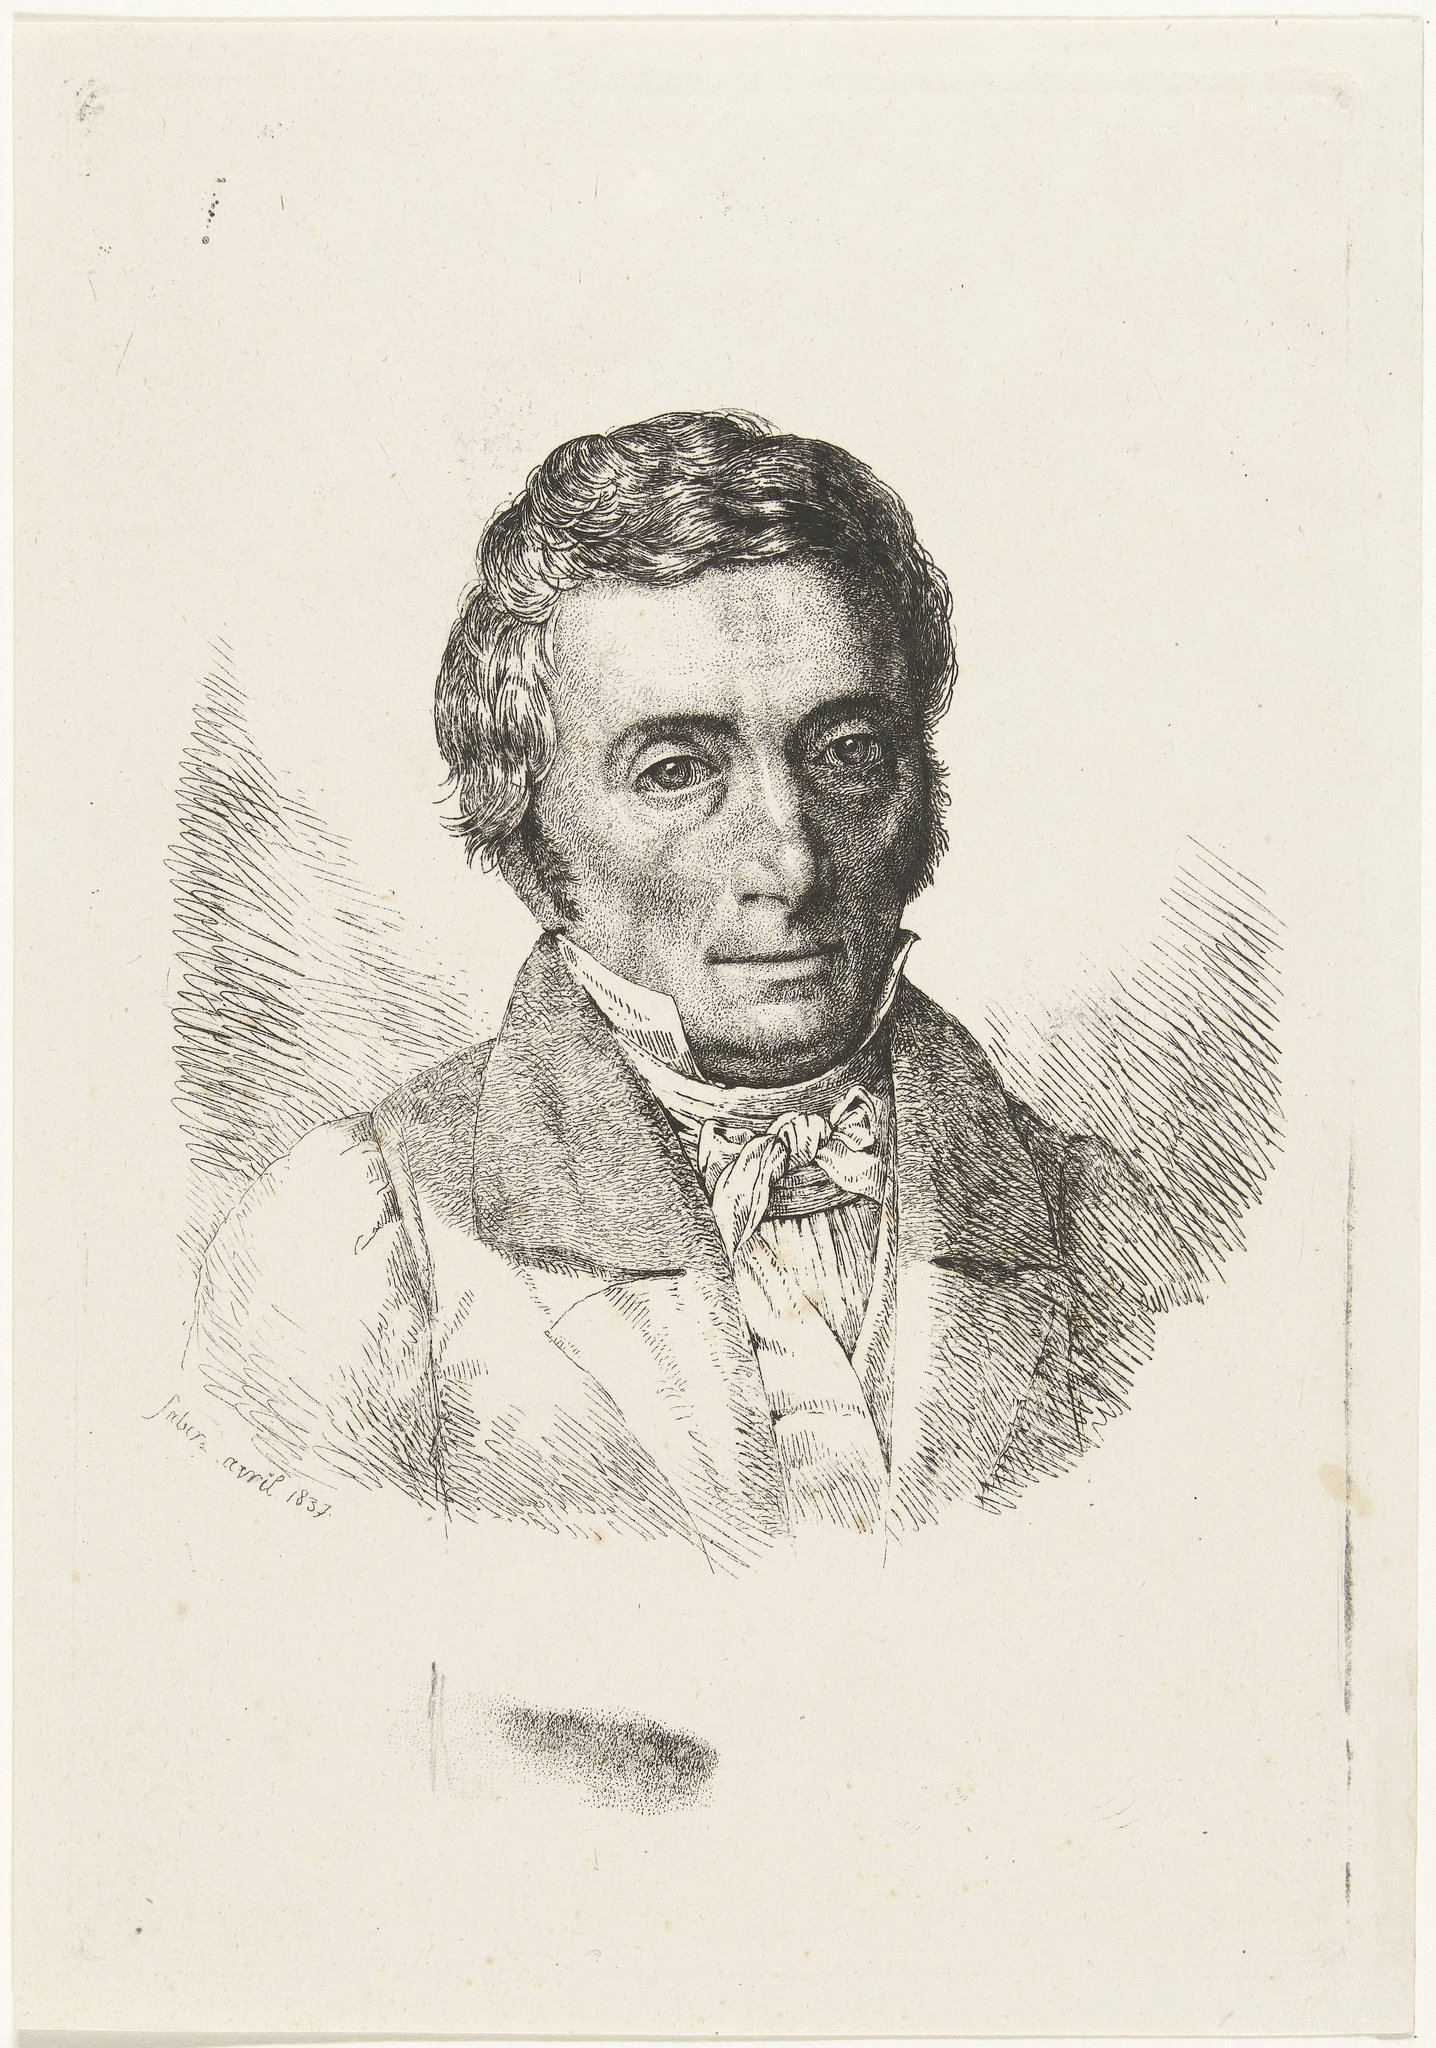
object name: print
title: Zelfportret van Frédéric Théodore Faber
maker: frédéric théodore faber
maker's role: print maker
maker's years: 1782-1844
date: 1804-1837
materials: paper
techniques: drypoint, etching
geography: brussels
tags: print maker, frédéric théodore faber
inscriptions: collector's mark: Lugt 2228